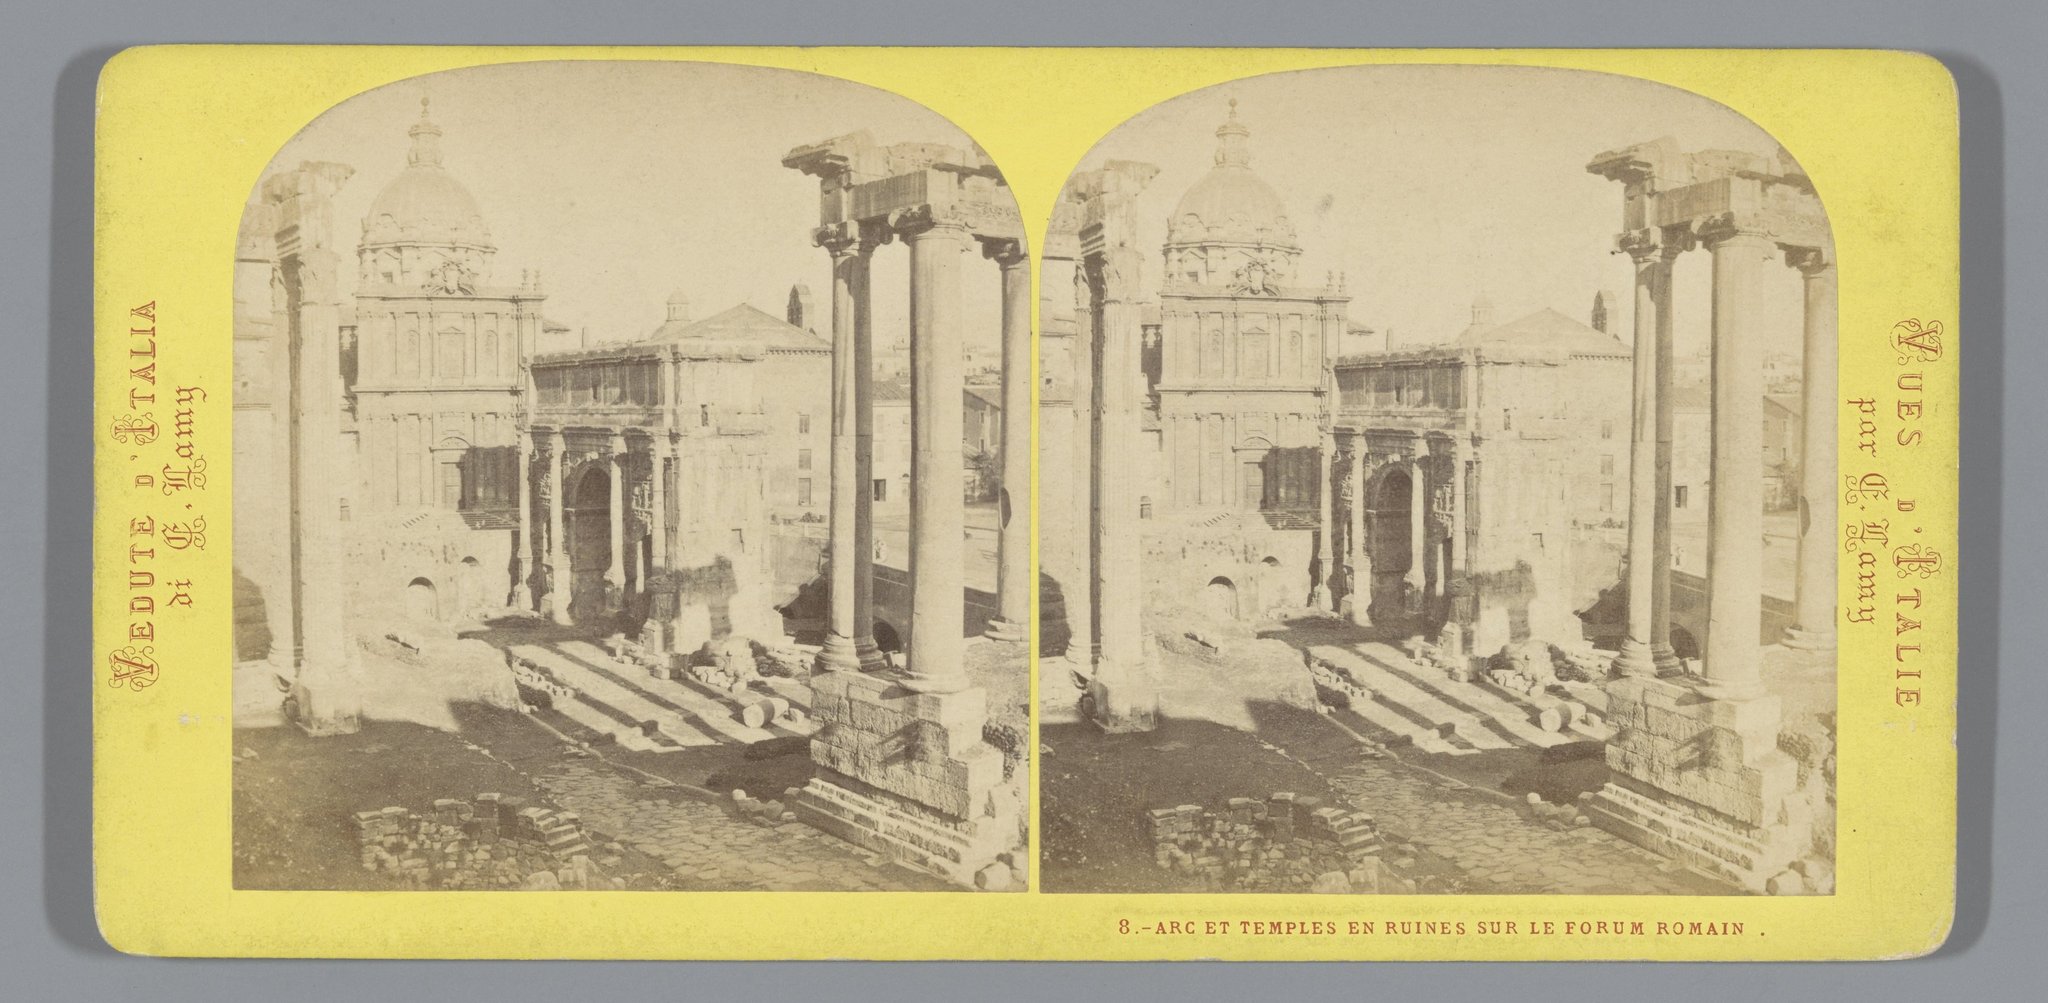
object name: stereograph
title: Boog van Septimius Severus op het Forum Romanum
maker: ernest eléonor pierre lamy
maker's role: publisher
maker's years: 1828-1900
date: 1861-1878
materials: cardboard, paper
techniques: albumen print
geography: rome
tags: triumphal arch, monument, statue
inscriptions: number: ‘8.’